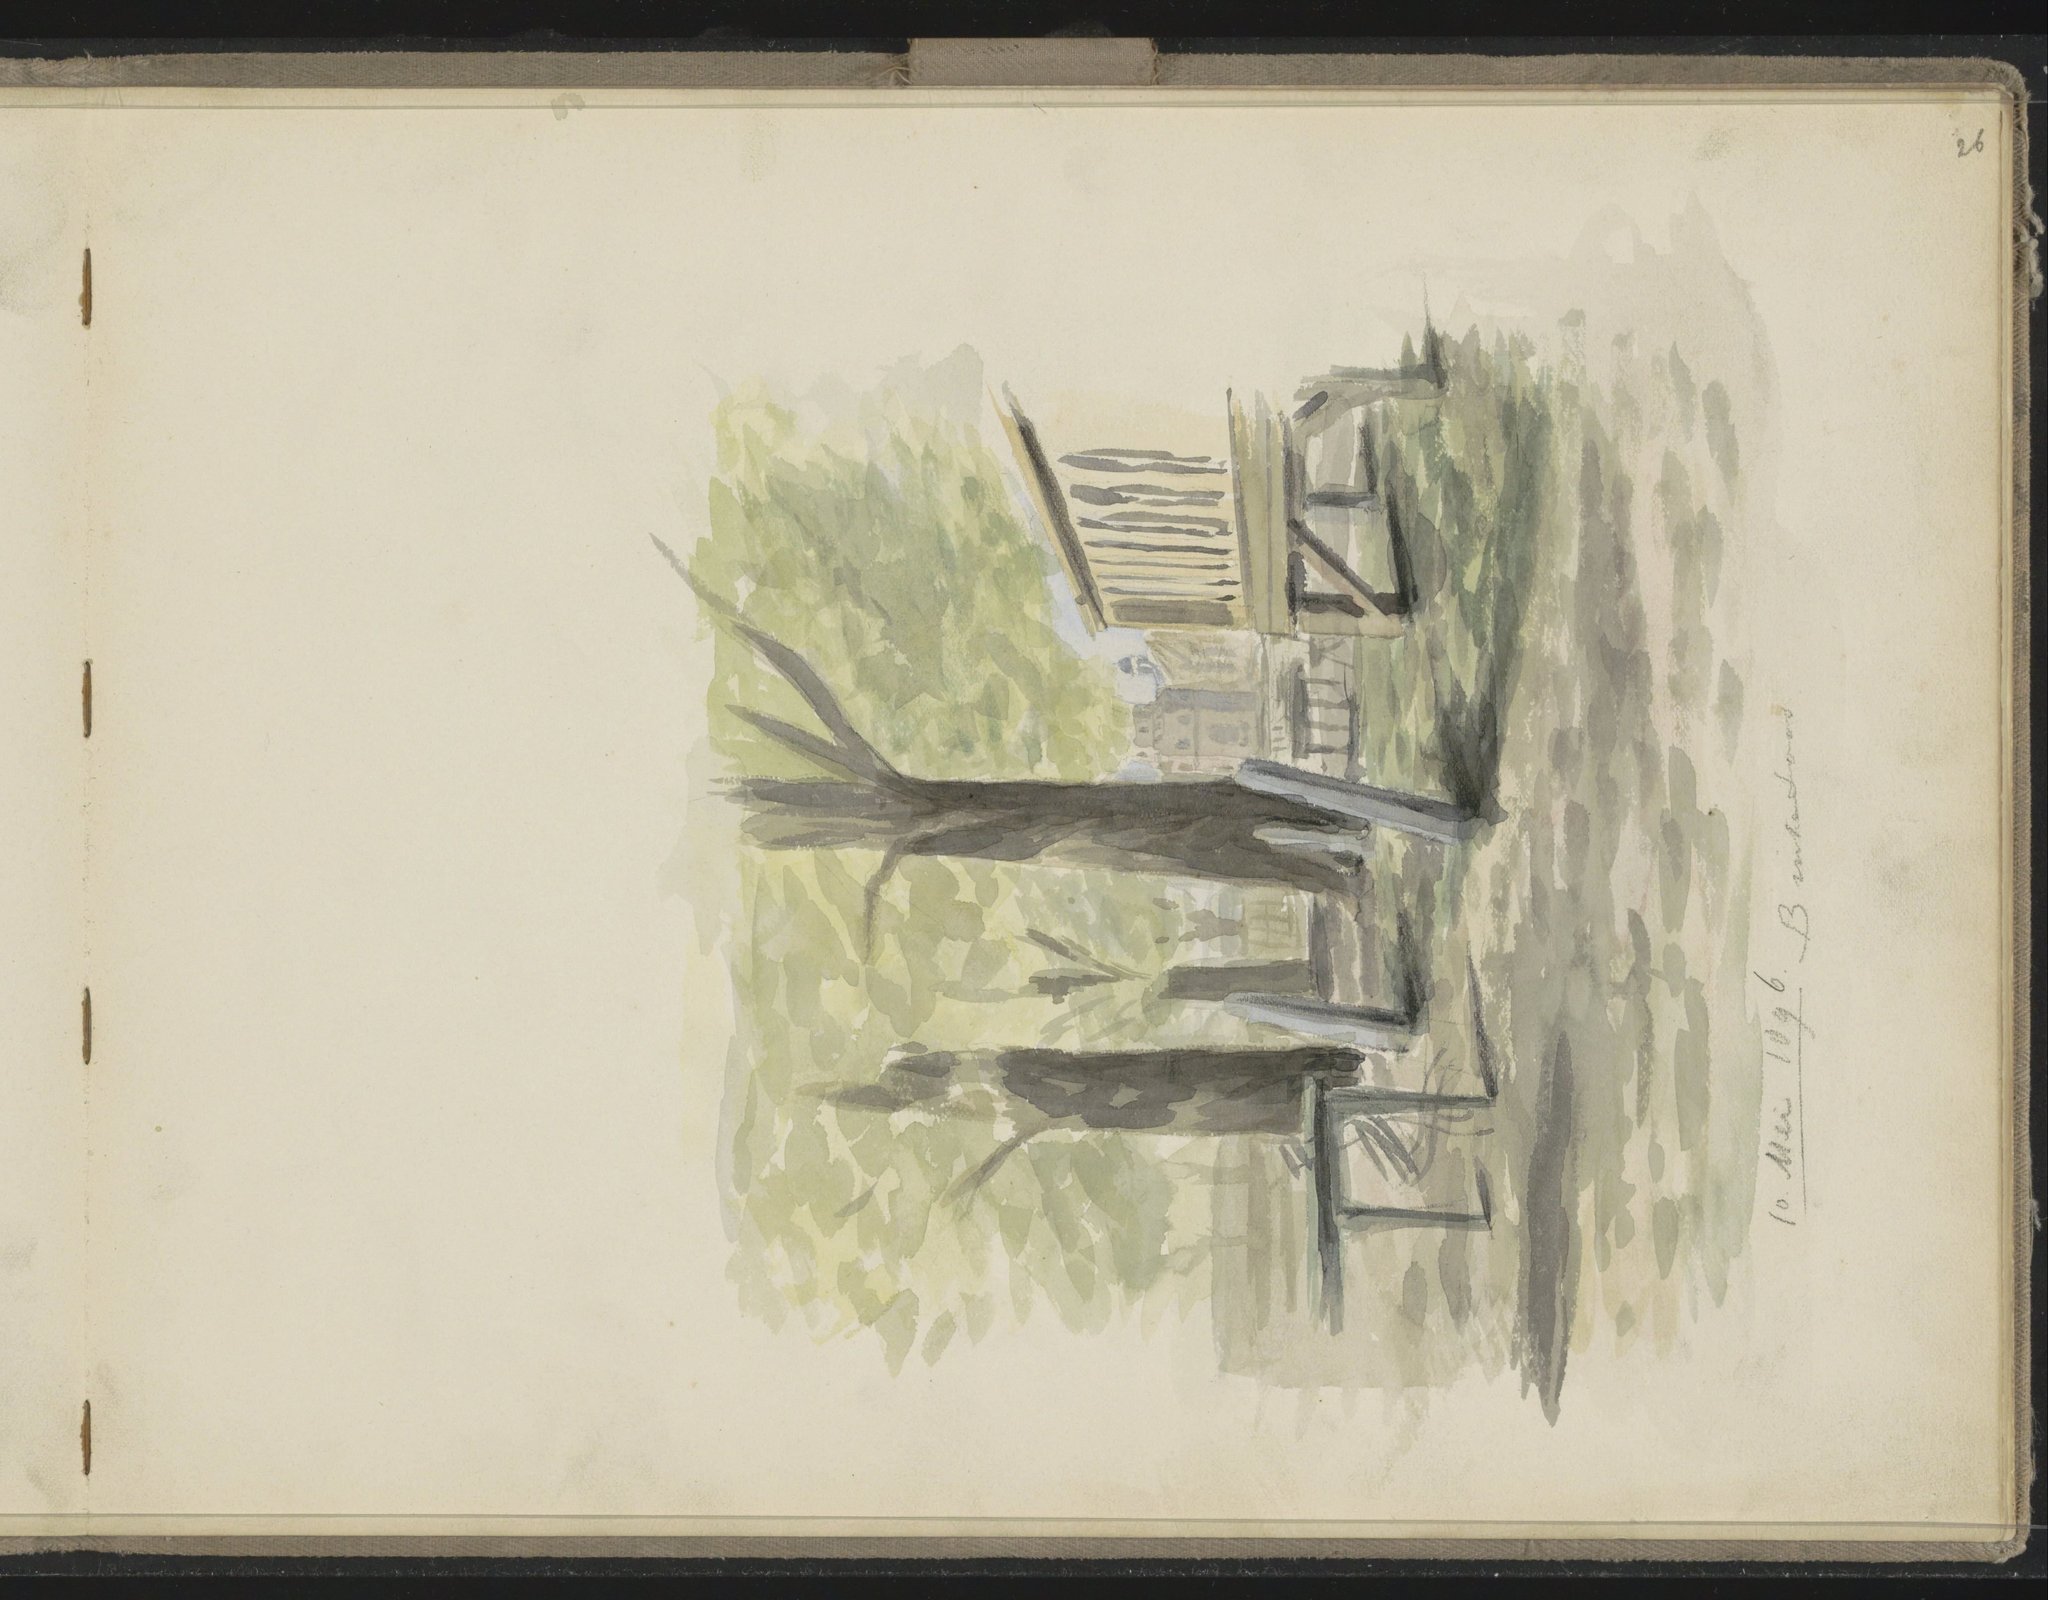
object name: sketchbook leaf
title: Buitensoos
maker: chris huidekooper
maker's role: draughtsman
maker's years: 1878-1939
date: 1805-1896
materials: paper, pencil, watercolor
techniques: brush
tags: open-air recreation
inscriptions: date and inscription: ‘10 Mei 1896/ Buitensoos’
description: Blad 26 recto uit een schetsboek met 32 bladen.